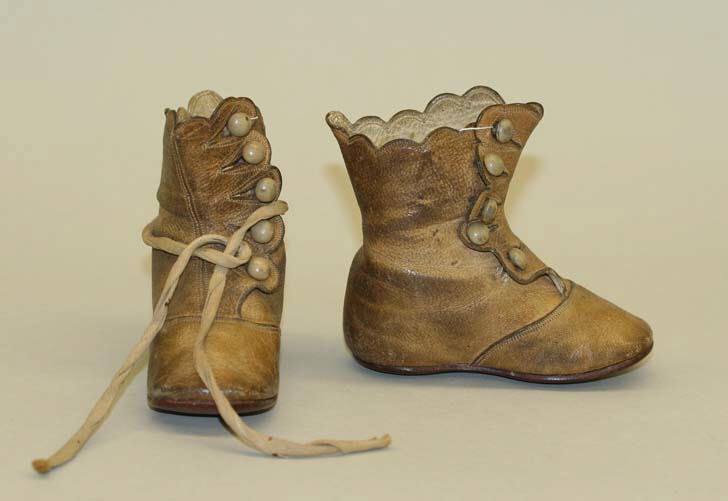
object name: shoe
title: Shoes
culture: american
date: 1800-1939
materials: leather